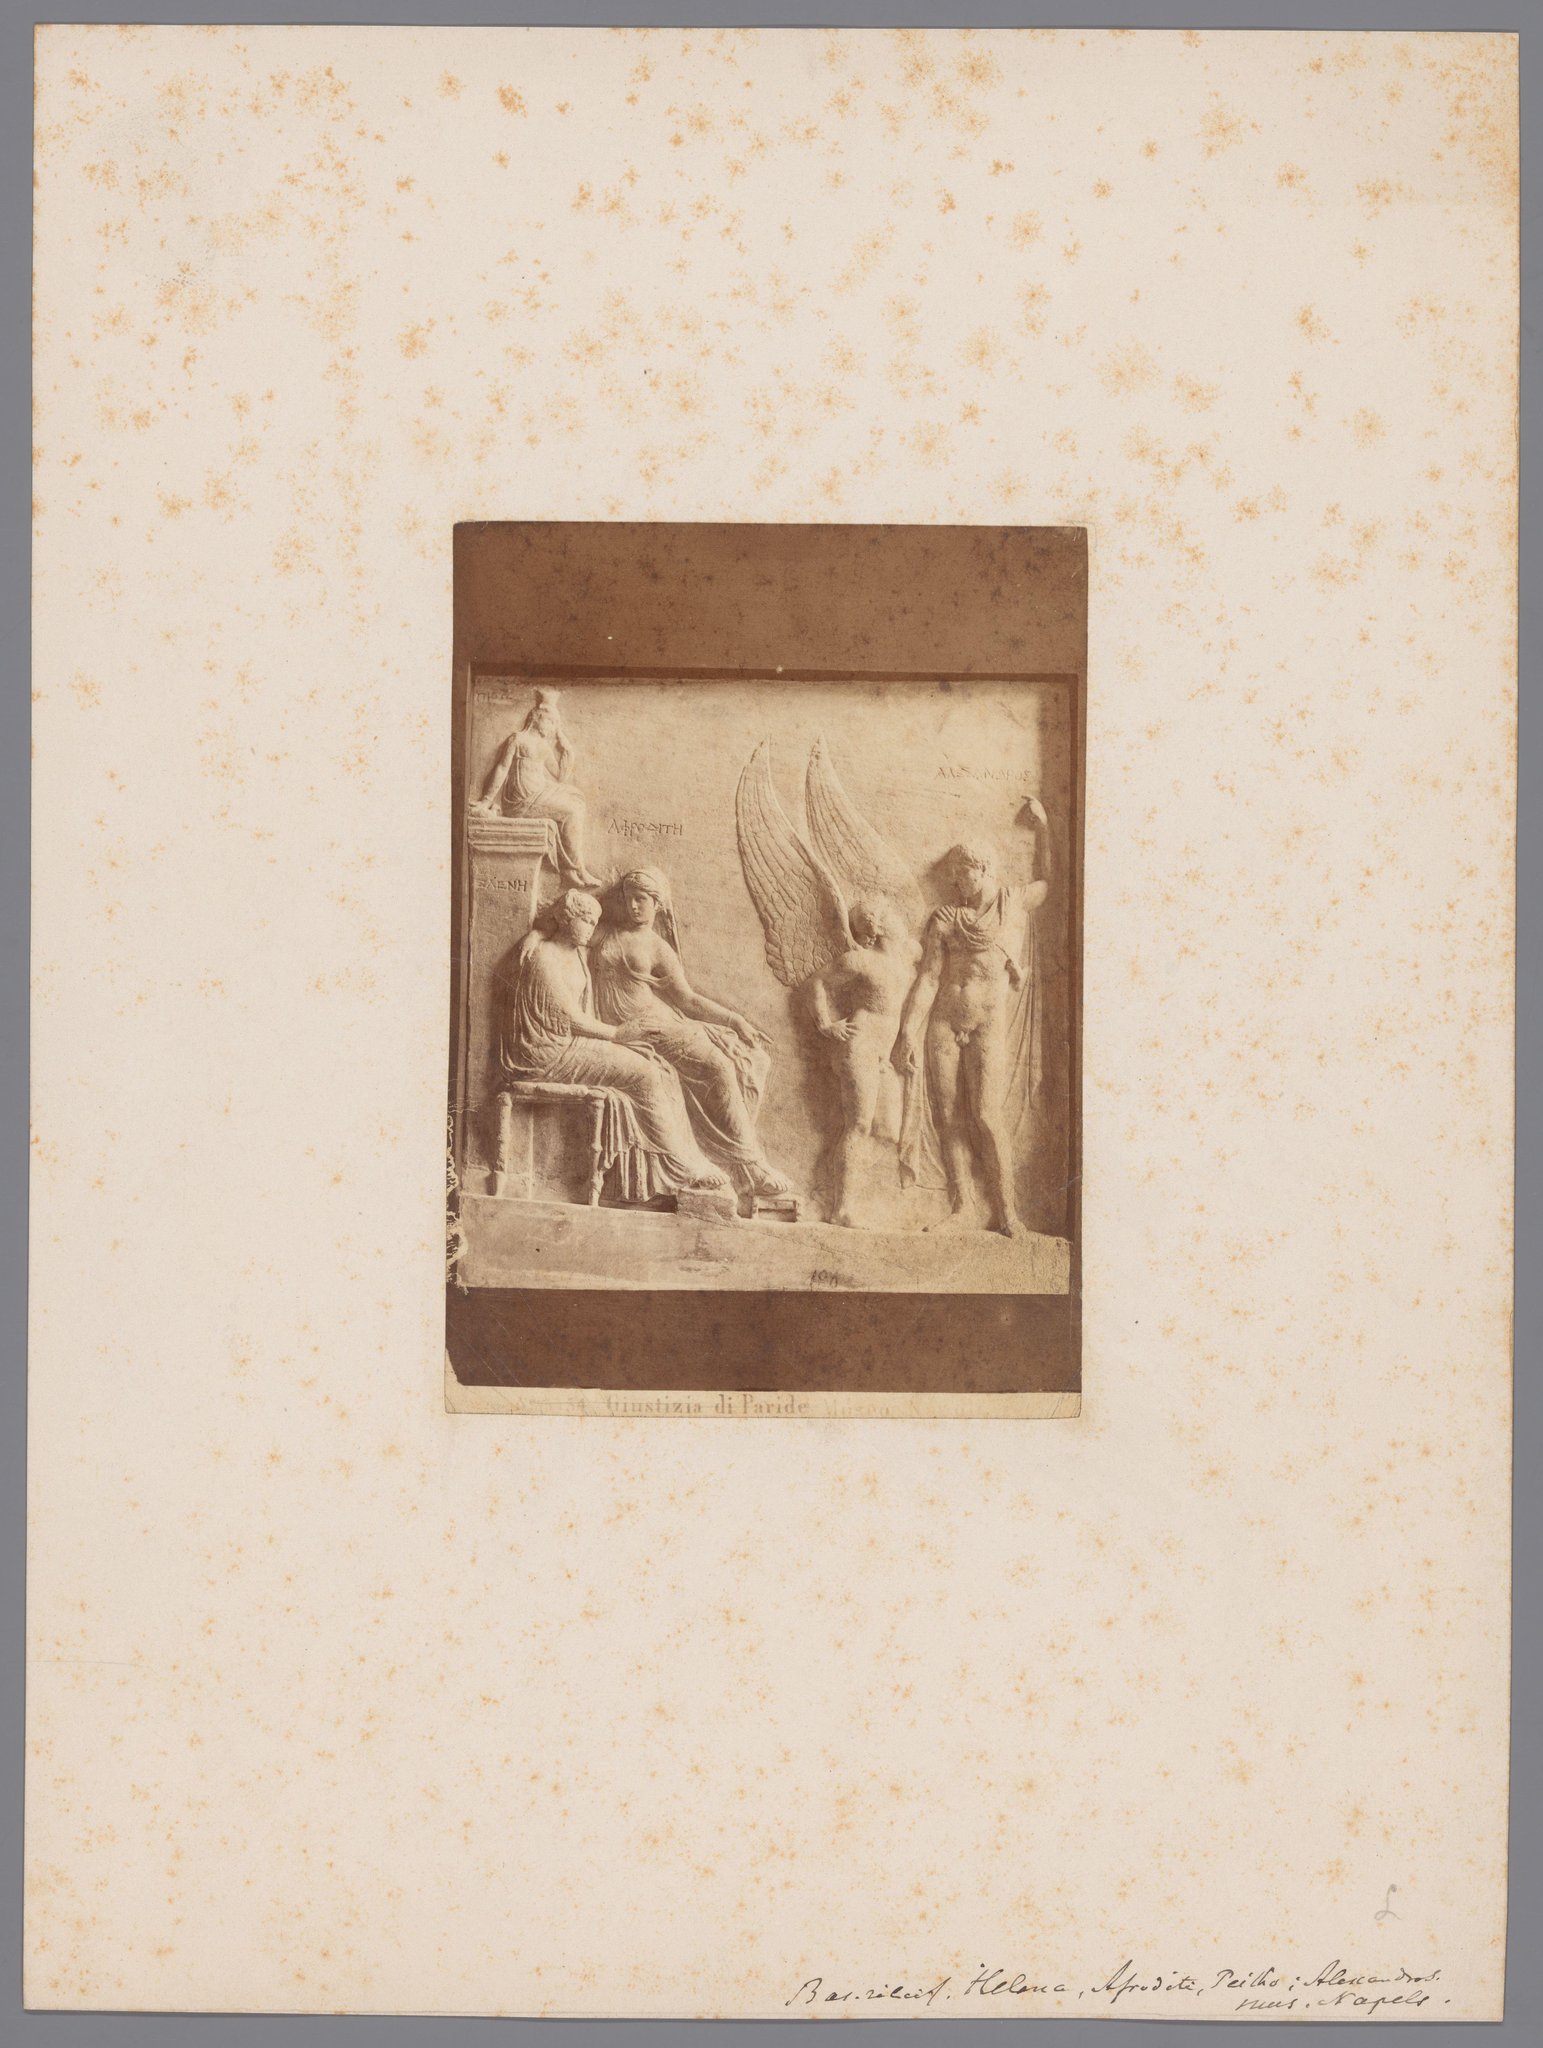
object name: photograph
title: Reliëf van het oordeel van Paris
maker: Anonymous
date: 1860-1890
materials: cardboard, paper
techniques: albumen print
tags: piece of sculpture, reproduction of a piece of sculpture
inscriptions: inscription: ‘Basrelief Helena, Afrodite, Peilko, Alexandros/ mus. Napels.’, number: ‘No 5[?]54’, collector's mark: ‘VOSMAER’